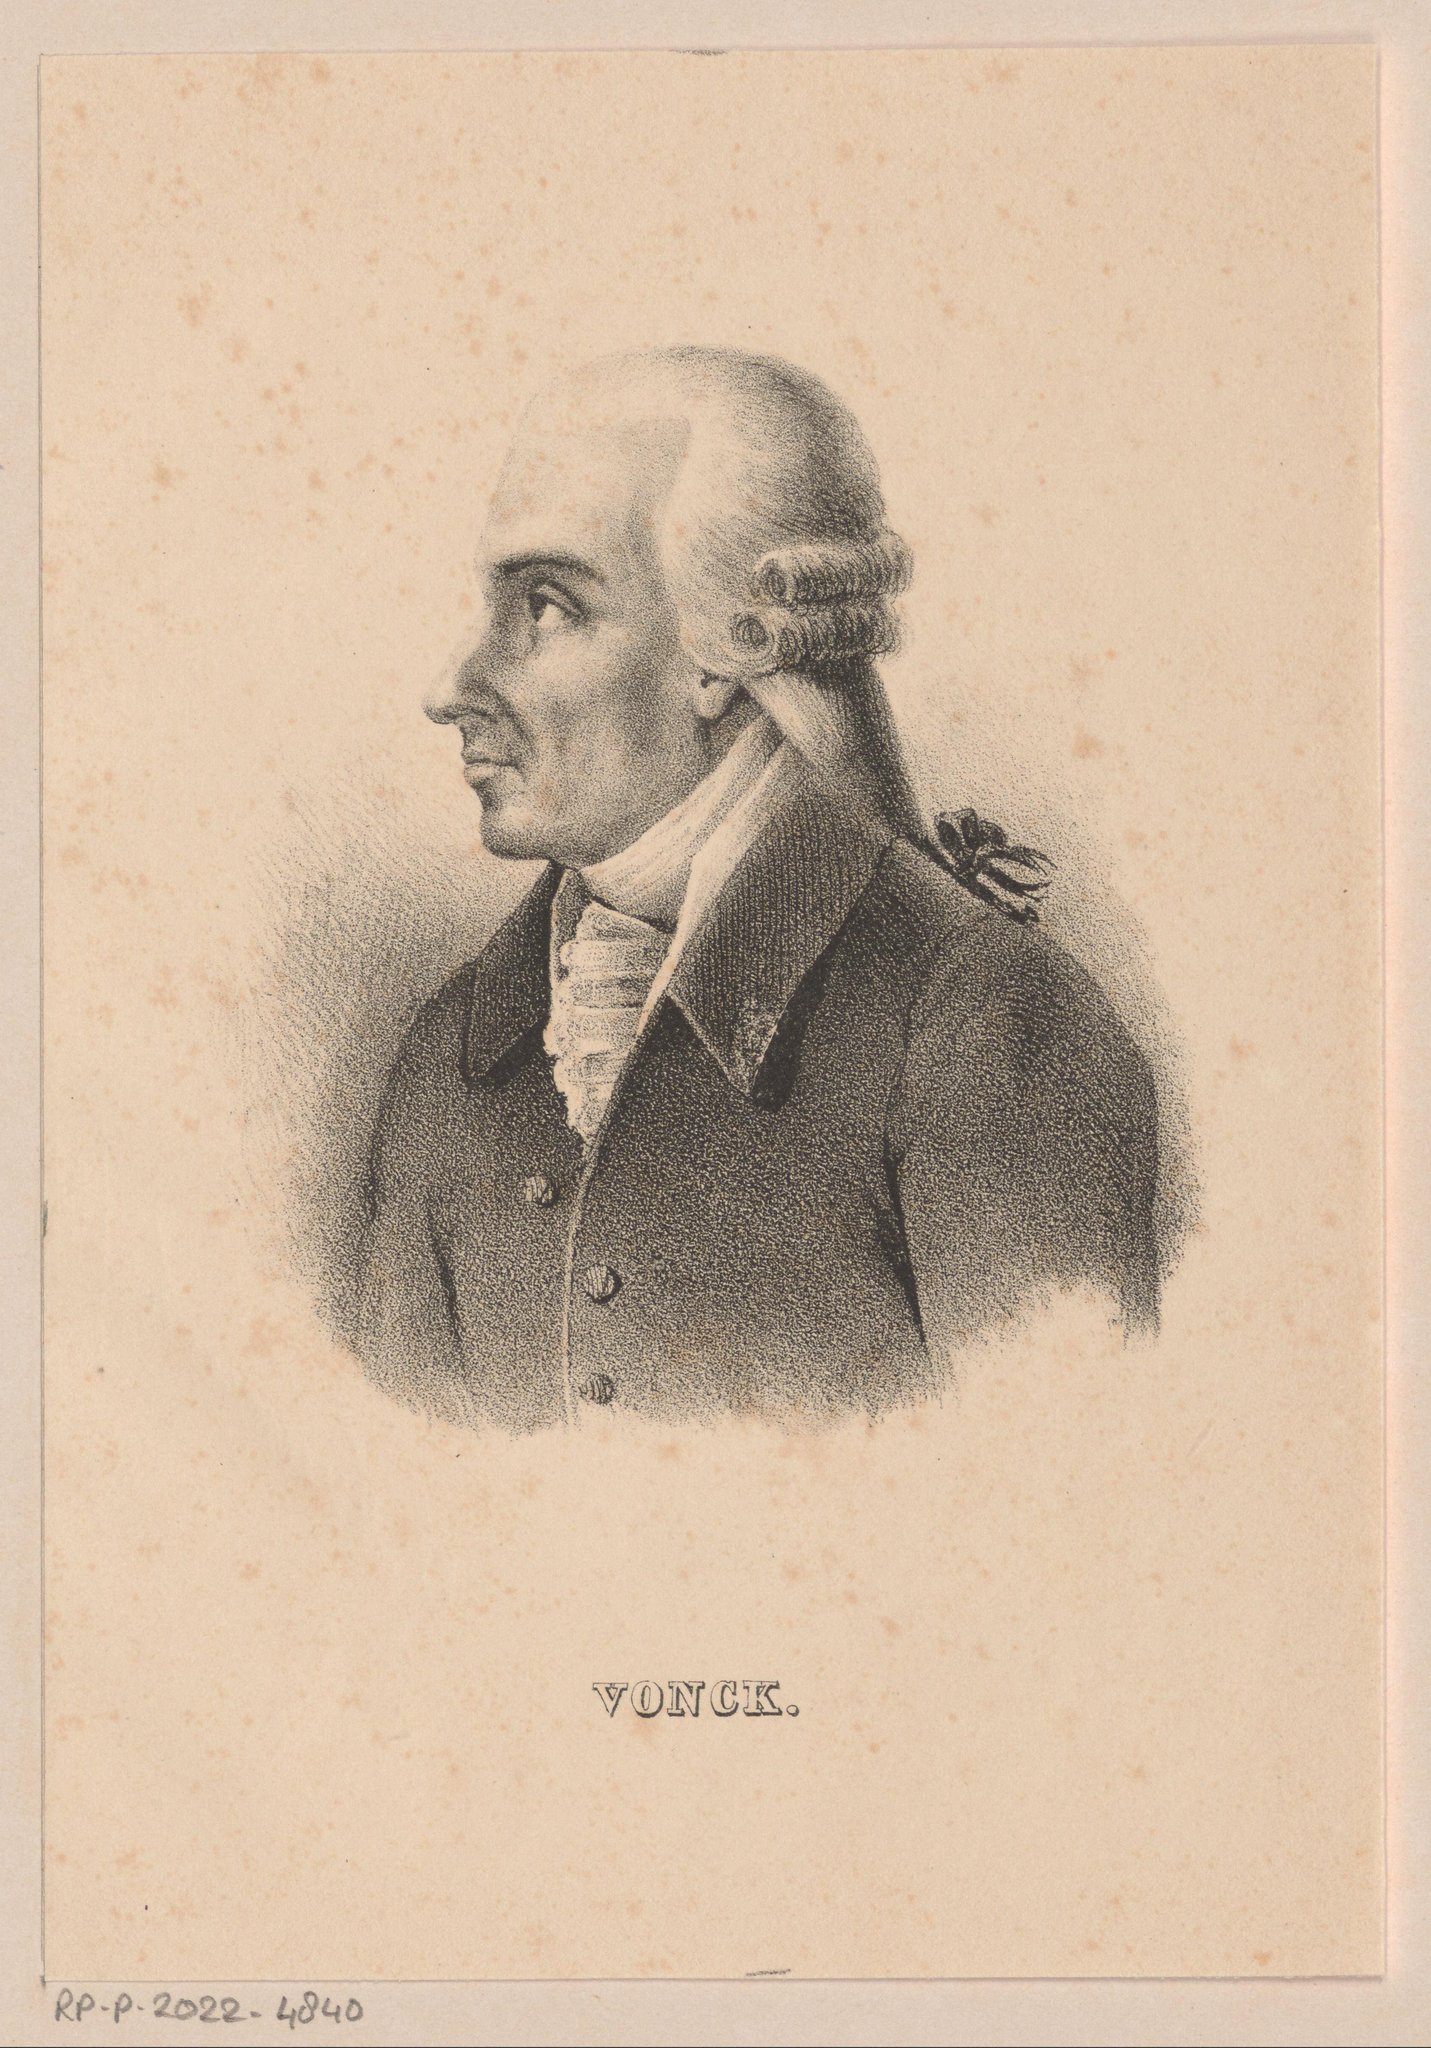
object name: print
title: Portret van een man, mogelijk Lambertus Christoffel Vonck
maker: Anonymous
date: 1800-1850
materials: paper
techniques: lithograph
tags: rotterdam, historical persons, lawyer, attorney at law, politician, e.g. party leader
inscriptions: collector's mark: Lugt 2166